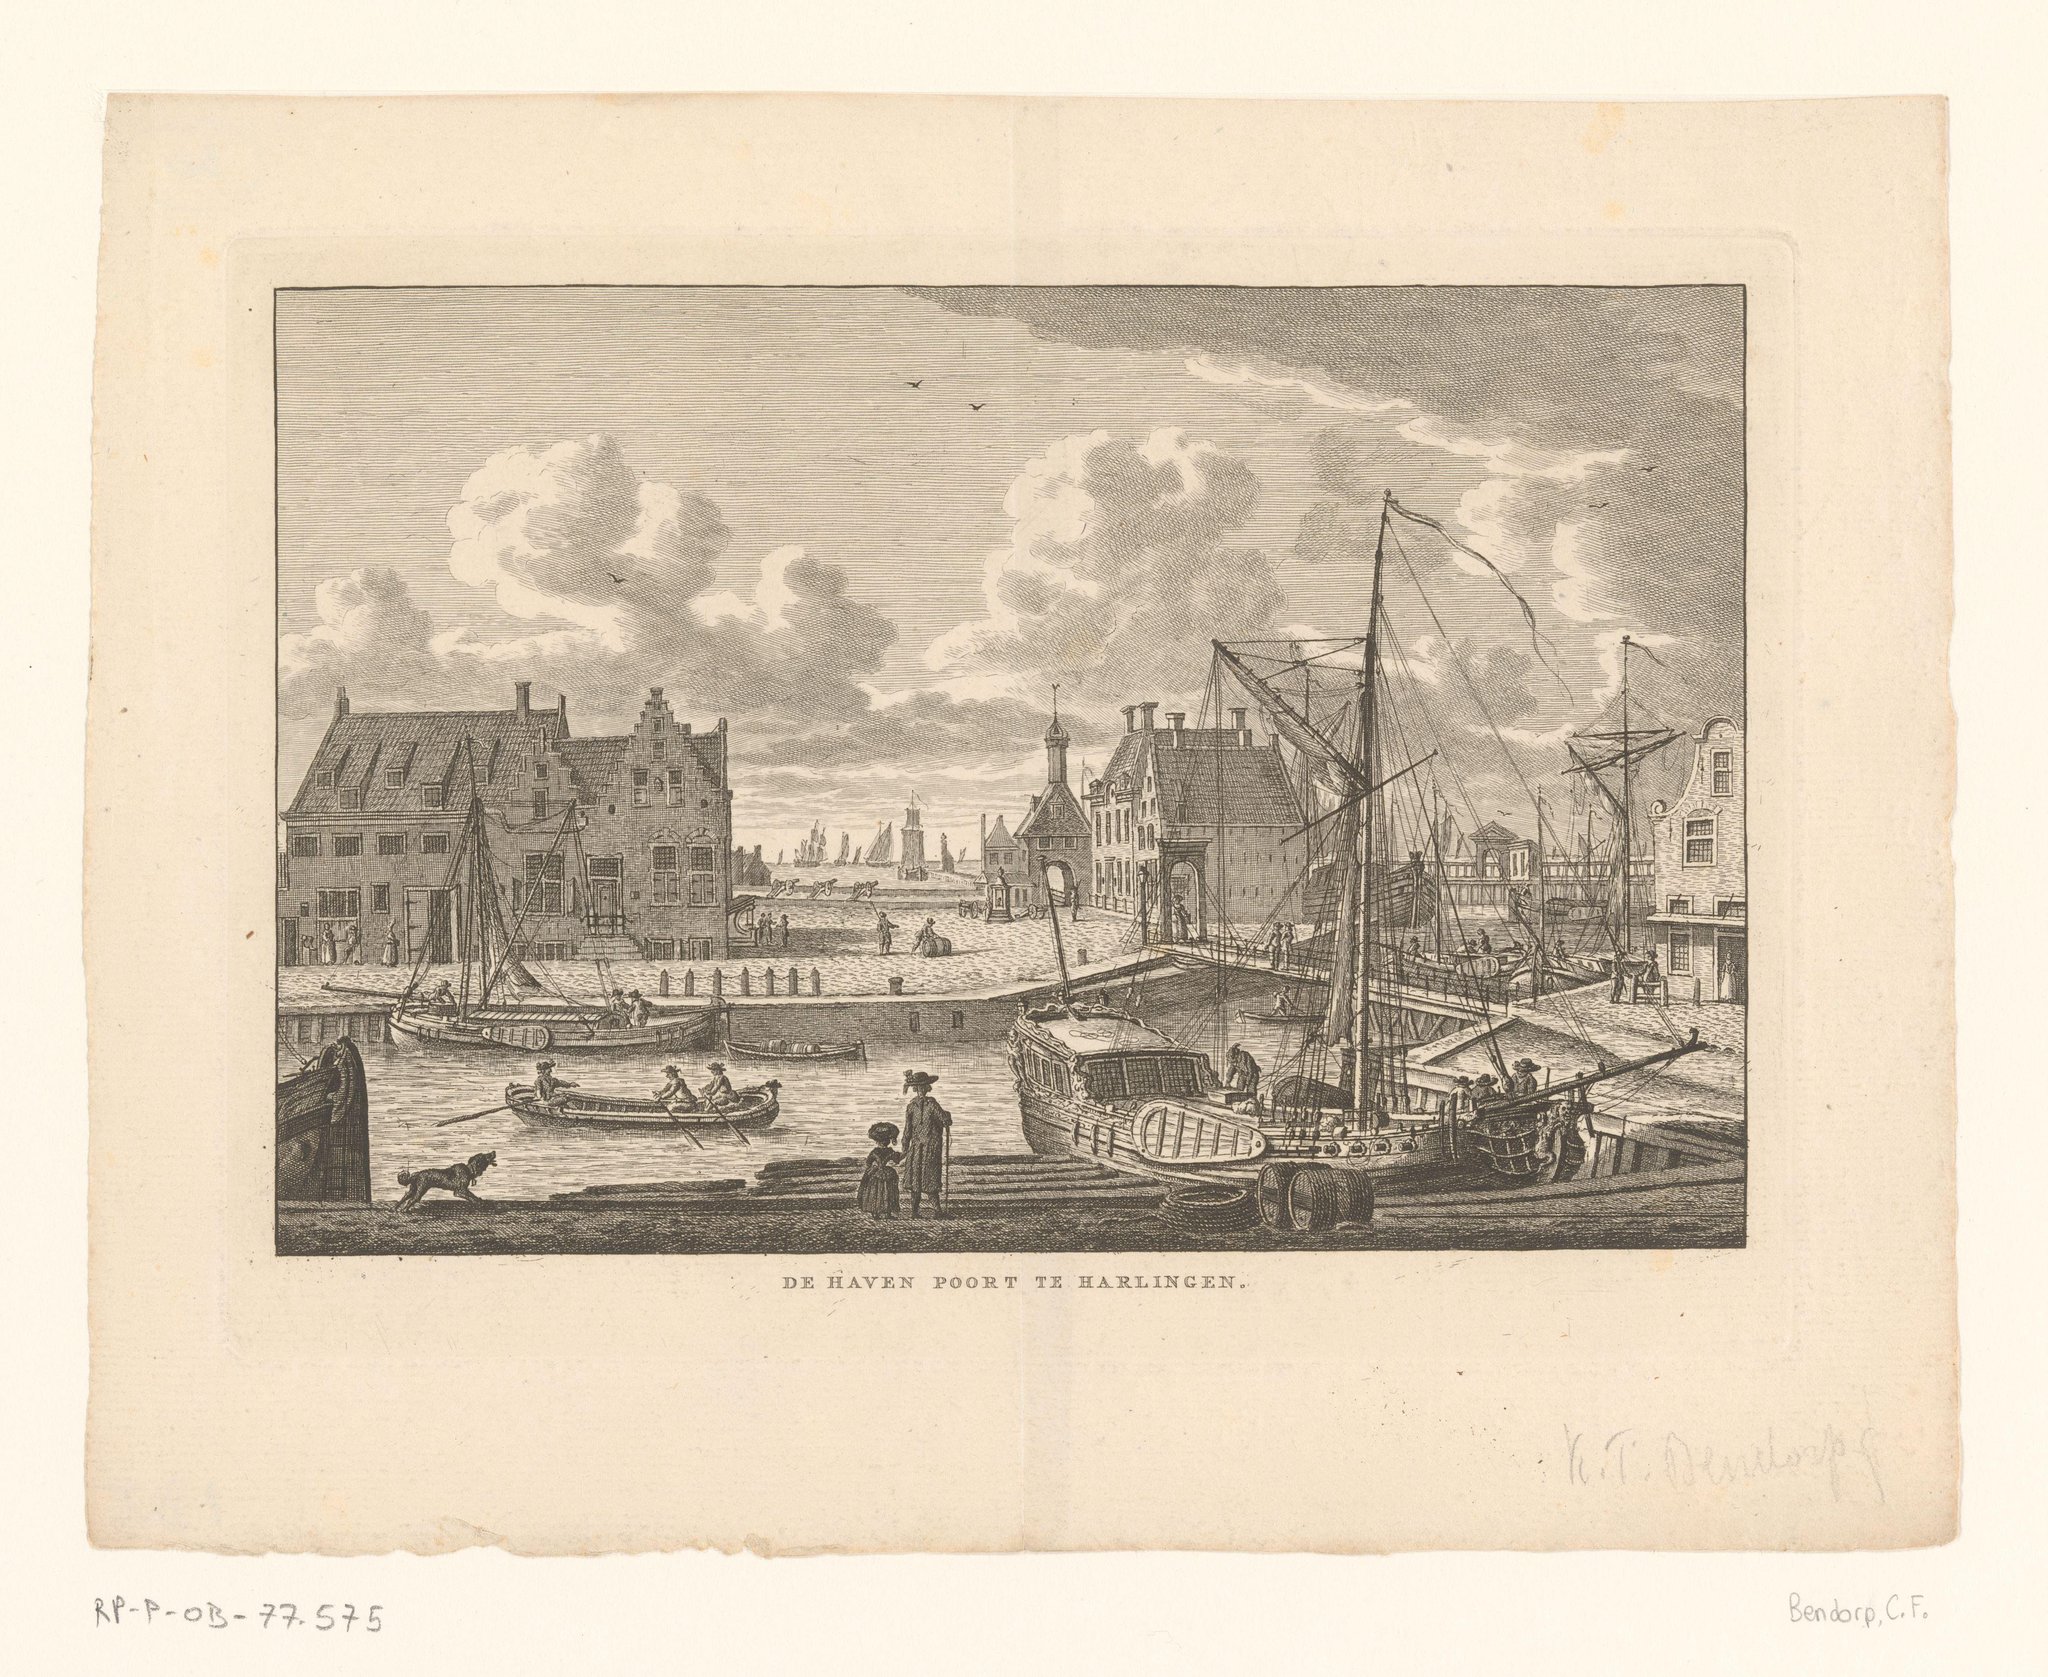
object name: print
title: Vaderlandsche gezichten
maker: carel frederik bendorp (i)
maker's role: print maker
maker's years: 1736-1814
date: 1786-1792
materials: paper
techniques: engraving, etching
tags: harbour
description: Prent waarschijnlijk uit: Vaderlandsche gezichten, of afbeeldingen van den tegenwoordigen staat der Vereenigde Nederlanden (…). Amsterdam: Hendrik Gartman, Willem Vermandel en Jan Willem Smit, 1786-1792. Uitgegeven in afleveringen met ieder een eigen bifolium en inhoudsopgave. Alle prenten in deze publicatie zijn gemaakt door Carel Frederik Bendorp (I) en, in de meeste gevallen, gebaseerd op tekeningen van Jan Bulthuis. Latere staat uitgegeven door Maaskamp als onderdeel van een plaatwerk uit ca. 1824-1825 met 74 (ongenummerde) platen van de belangrijkste topografische gezichten en verschillende zeden en gewoonten in het Verenigd Koninkrijk der Nederlanden.